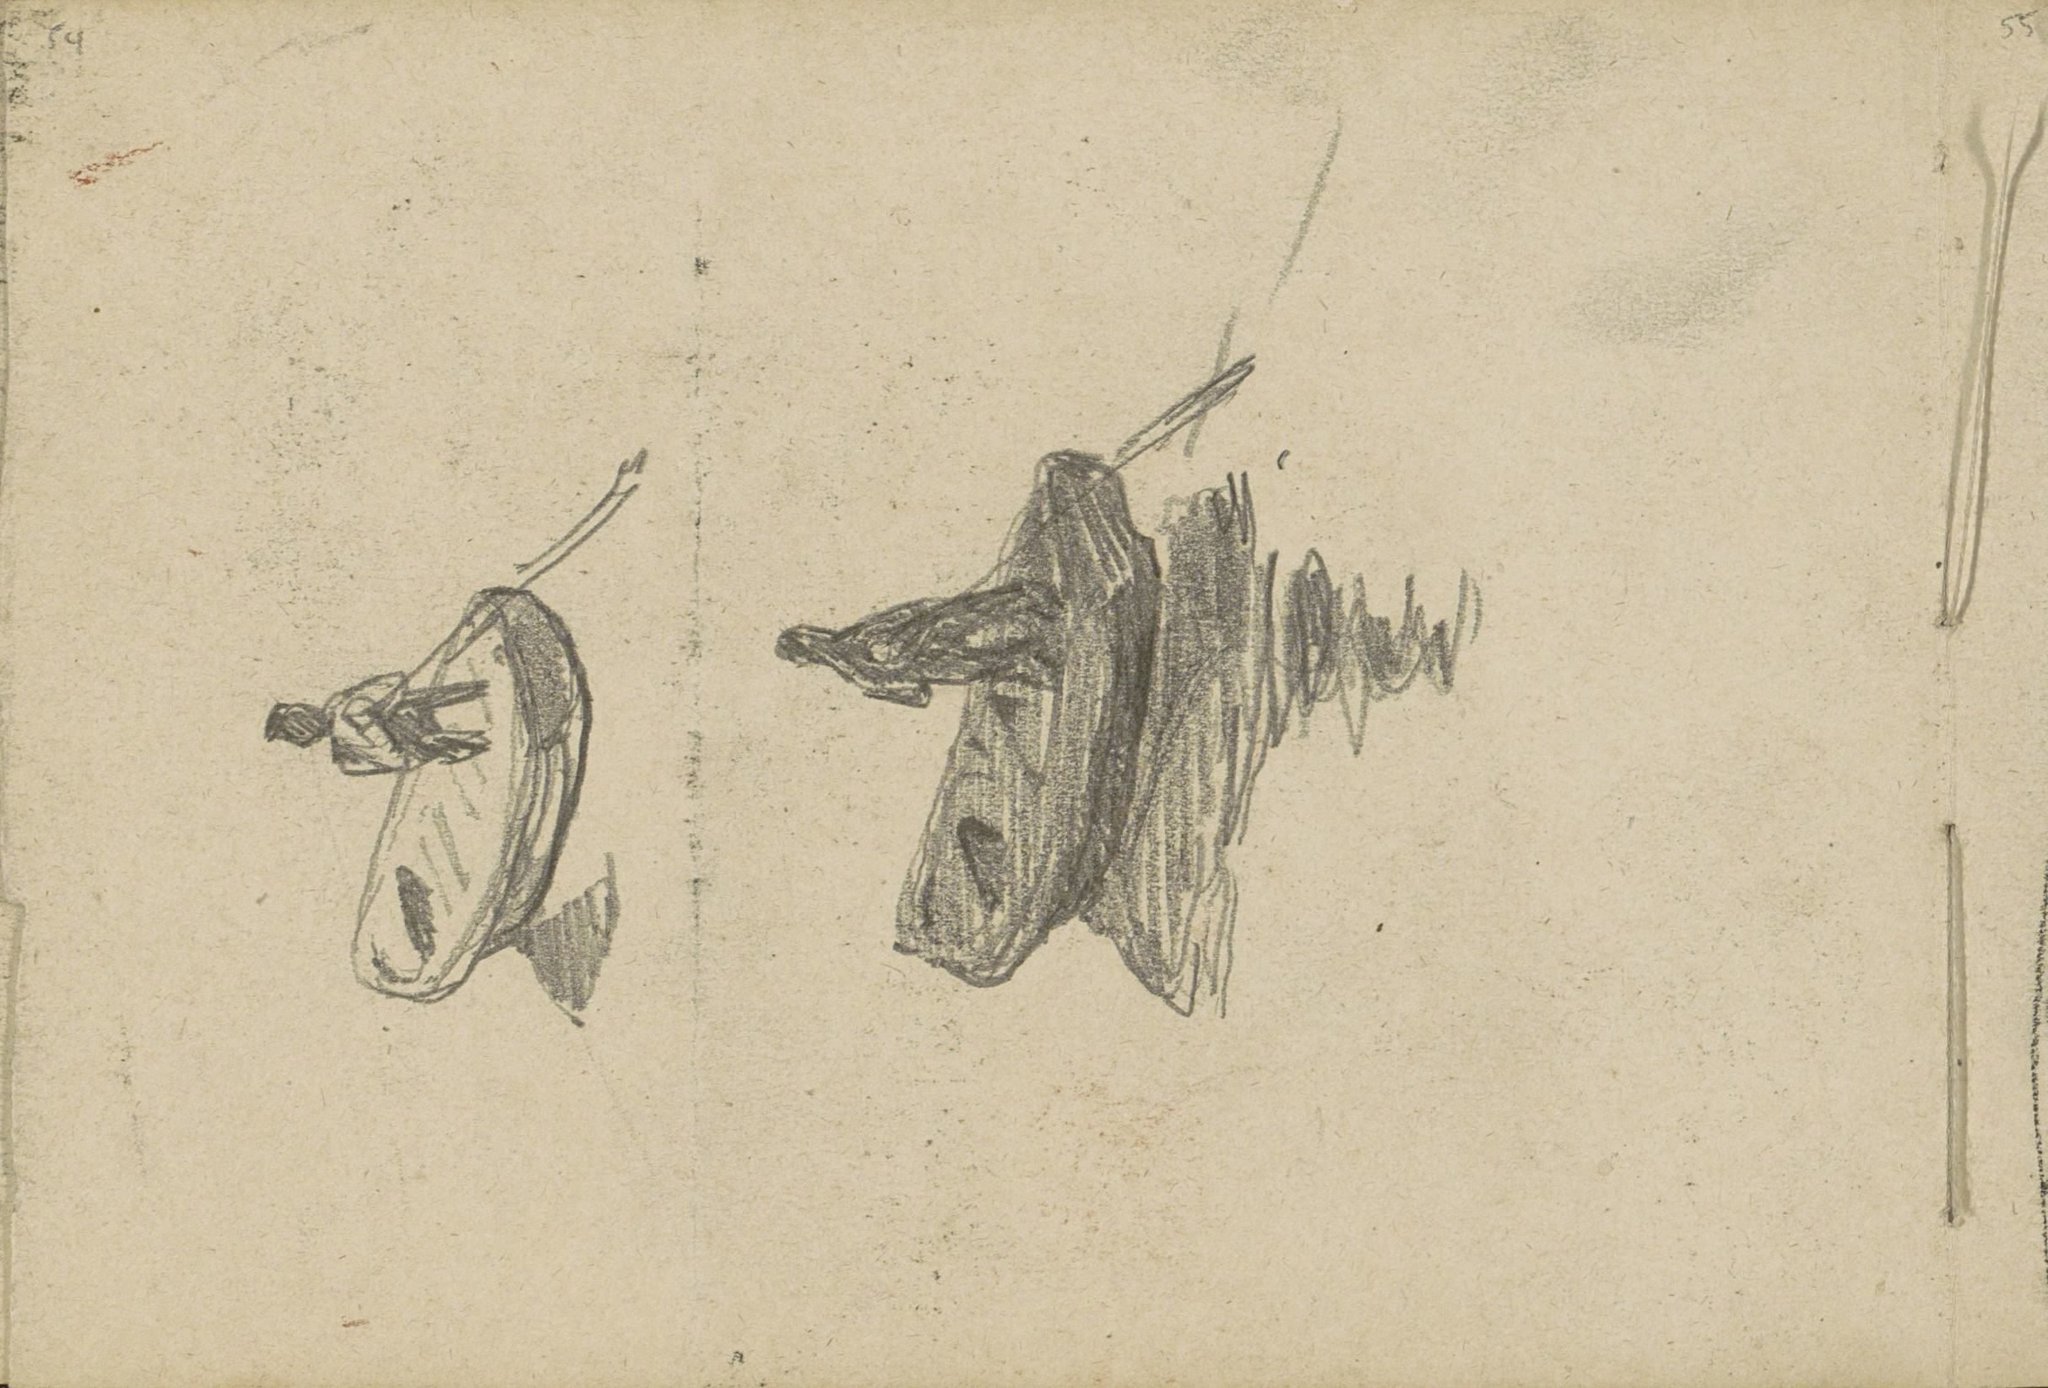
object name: sketchbook leaf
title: Twee studies van een staande figuur in een roeiboot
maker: willem witsen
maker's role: draughtsman, painter, print maker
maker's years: 1860-1923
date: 1897-1906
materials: paper, pencil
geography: rotterdam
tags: standing figure, rowing-boat, canoe, etc.